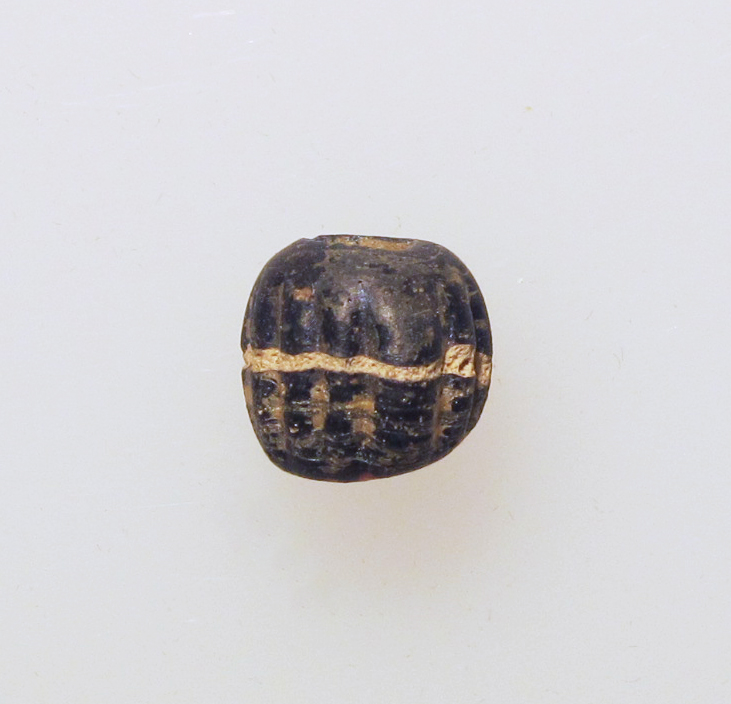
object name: bead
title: Glass bead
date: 7000 BCE-330 CE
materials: glass